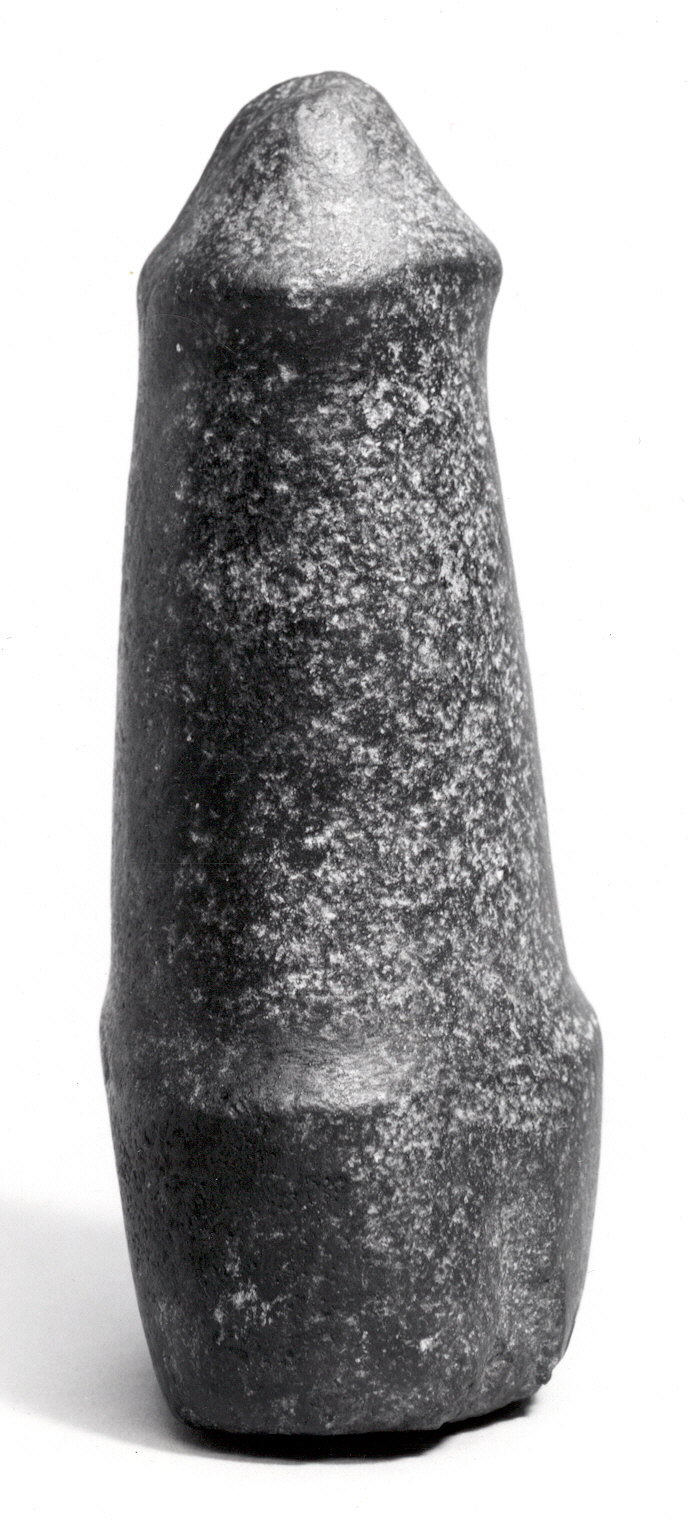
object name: pestle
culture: columbia river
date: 1701-1800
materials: stone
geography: united states